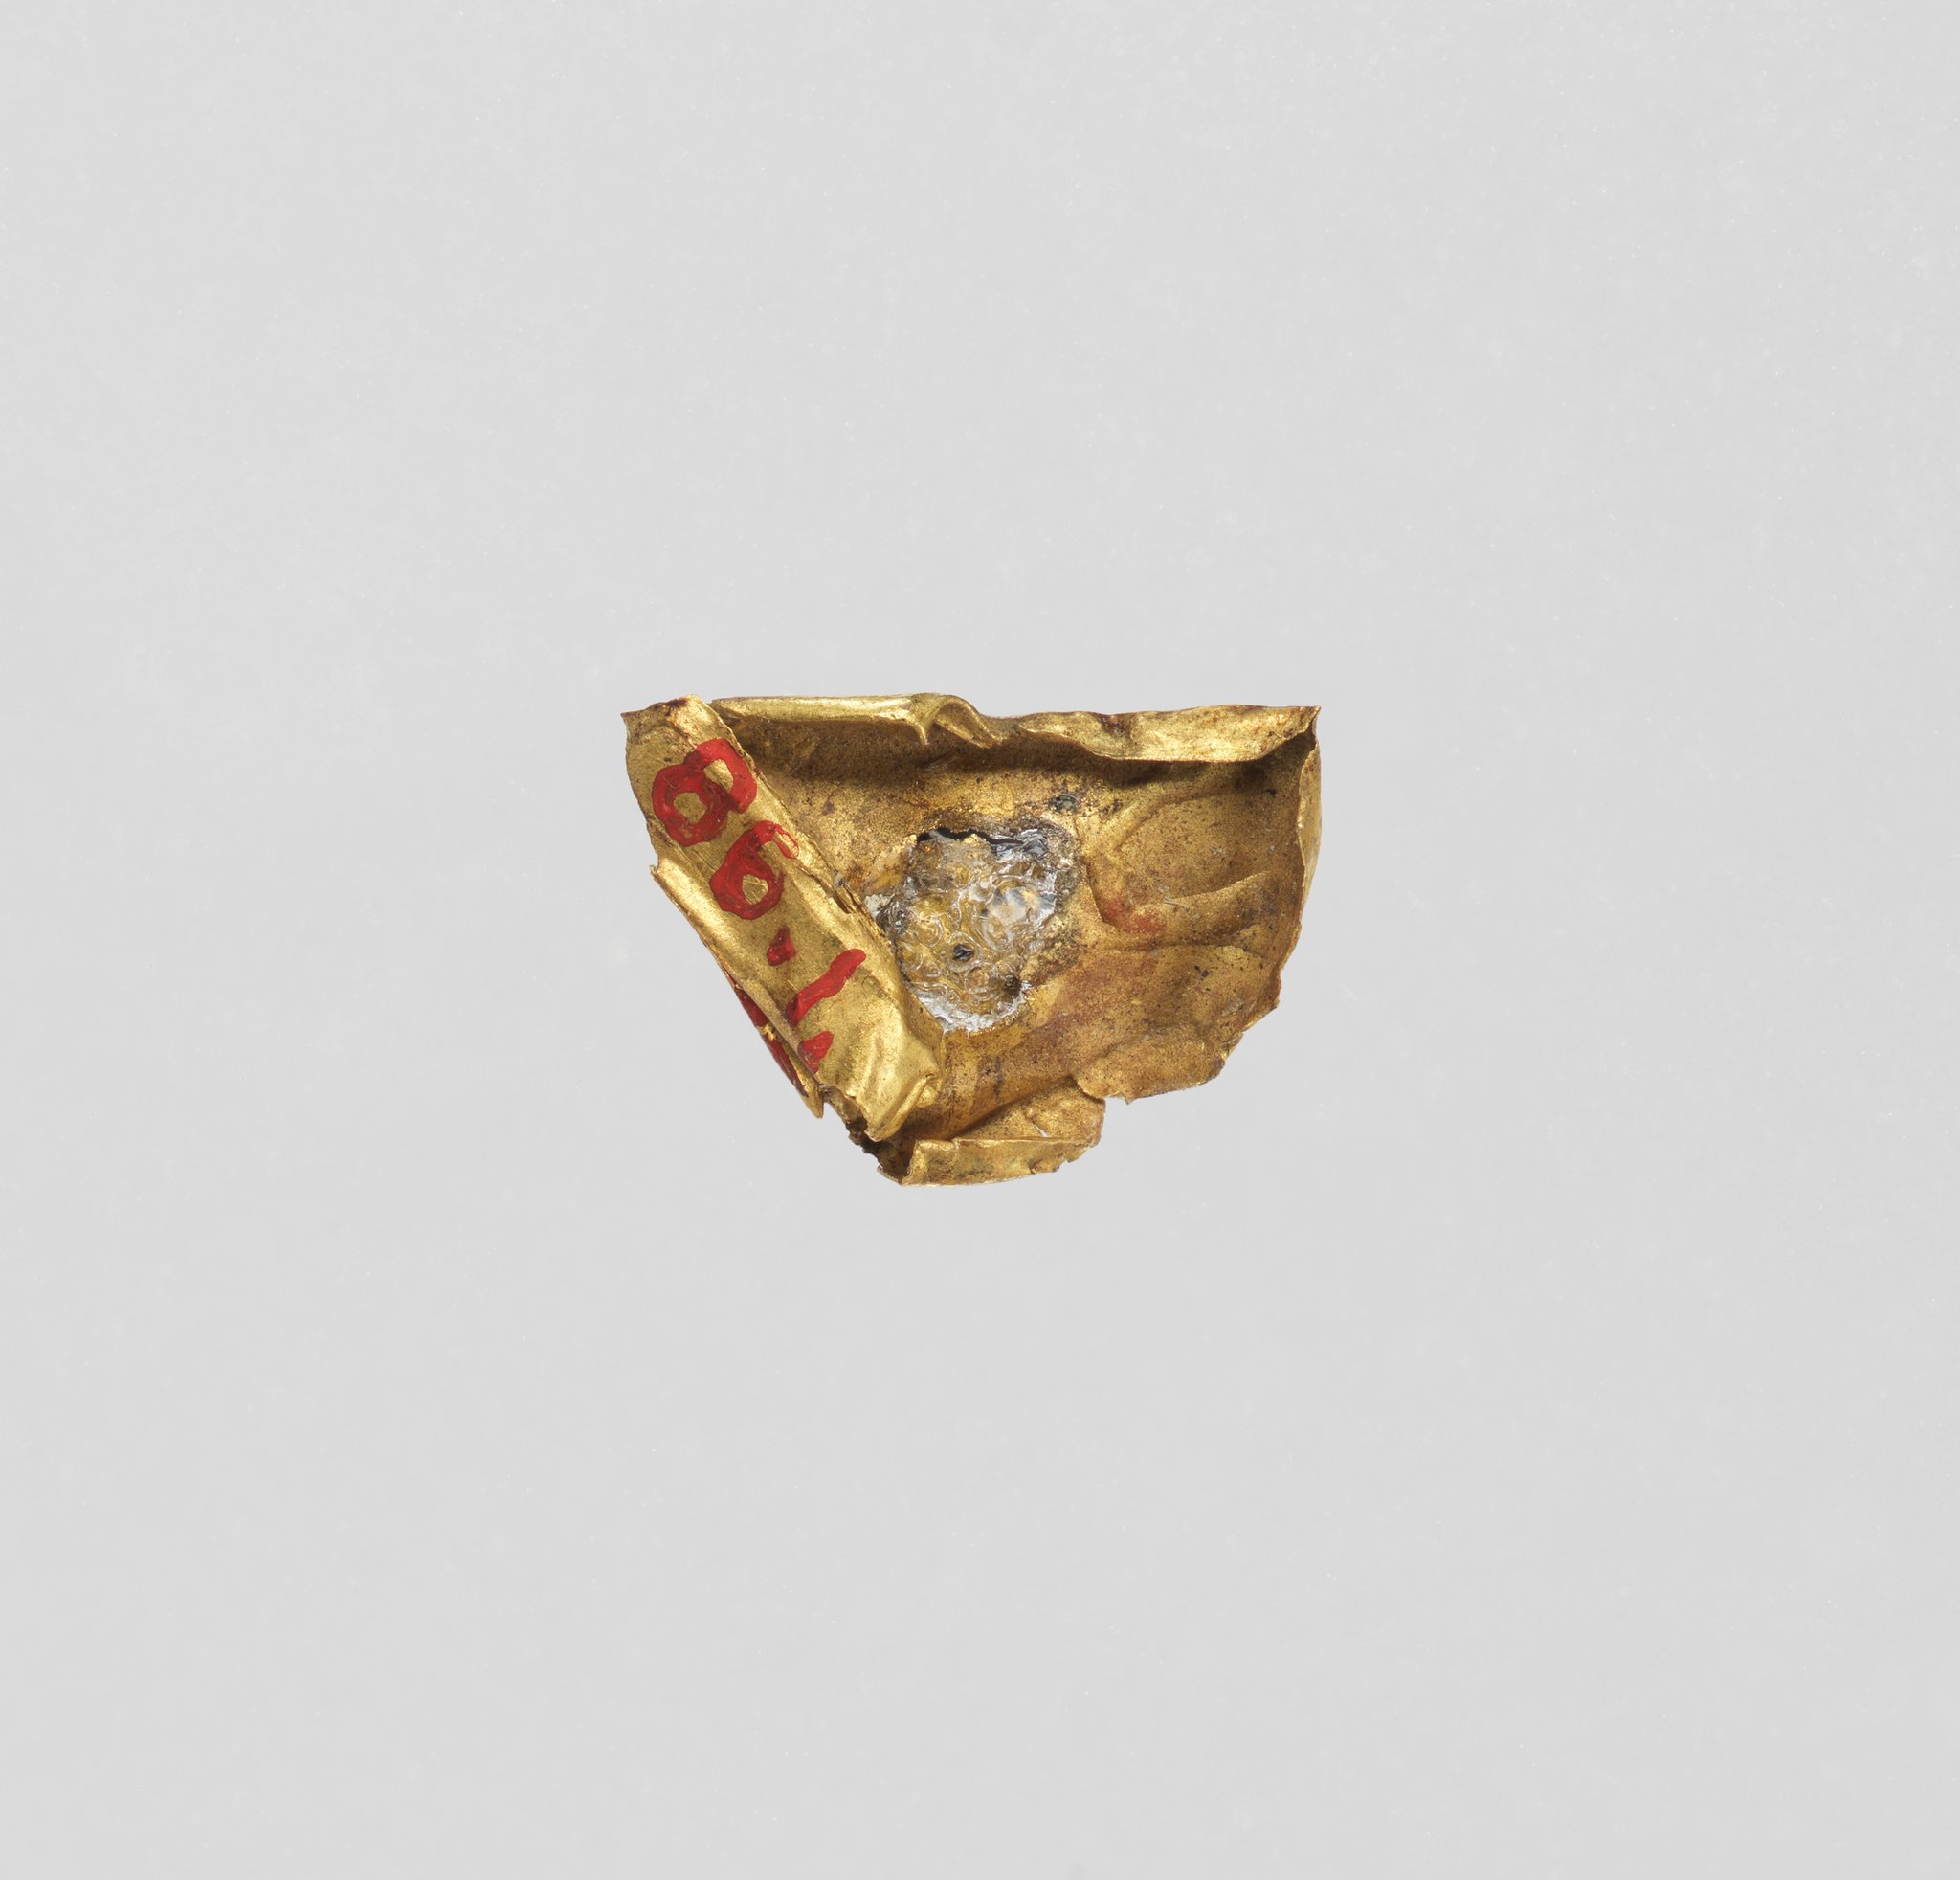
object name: amulet, from mummy dish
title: Heart Amulet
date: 305-30 BCE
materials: gold foil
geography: egypt